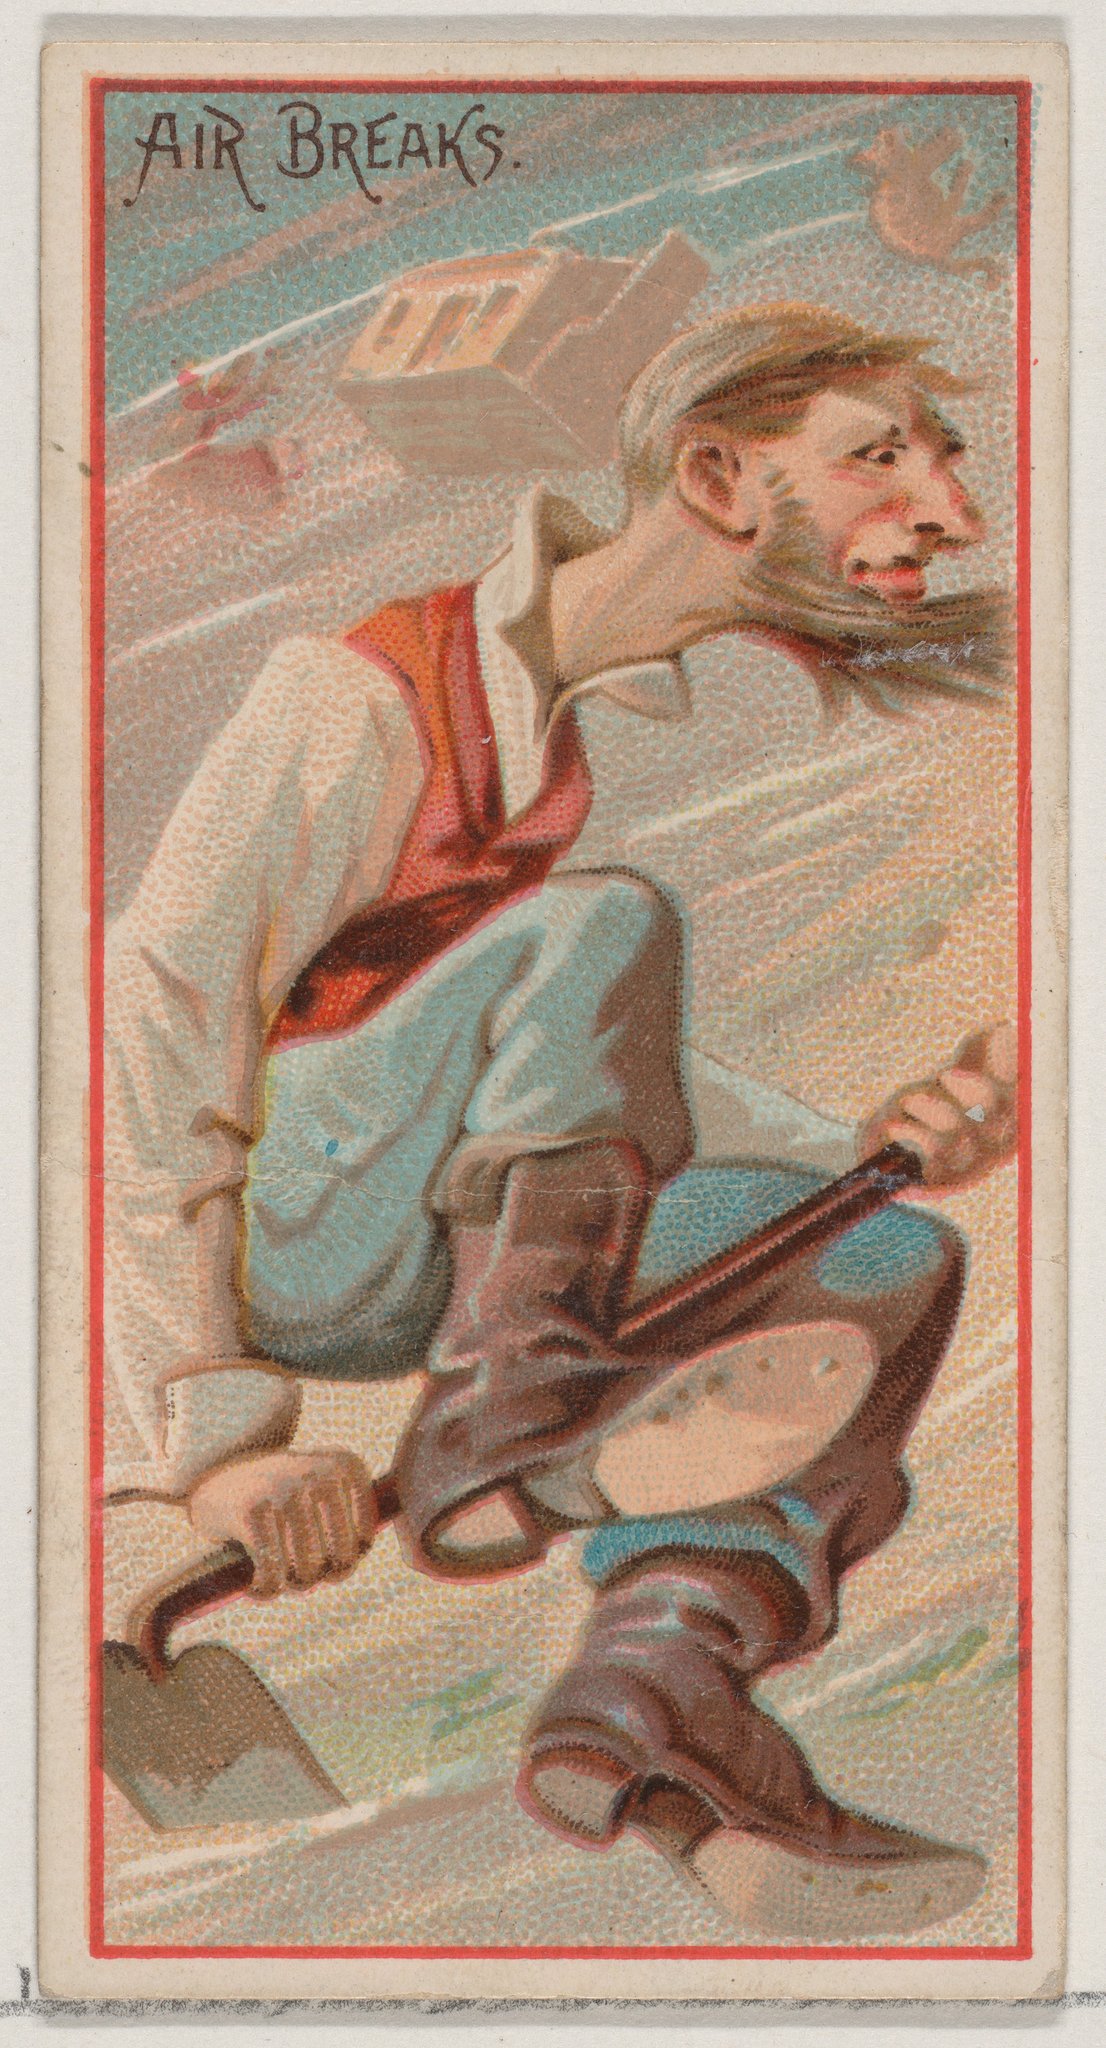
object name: print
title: Air Breaks, from the Jokes series (N87) for Duke brand cigarettes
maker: w. duke, sons & co.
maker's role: publisher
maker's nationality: american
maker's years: 1870-1920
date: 1890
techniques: color lithograph